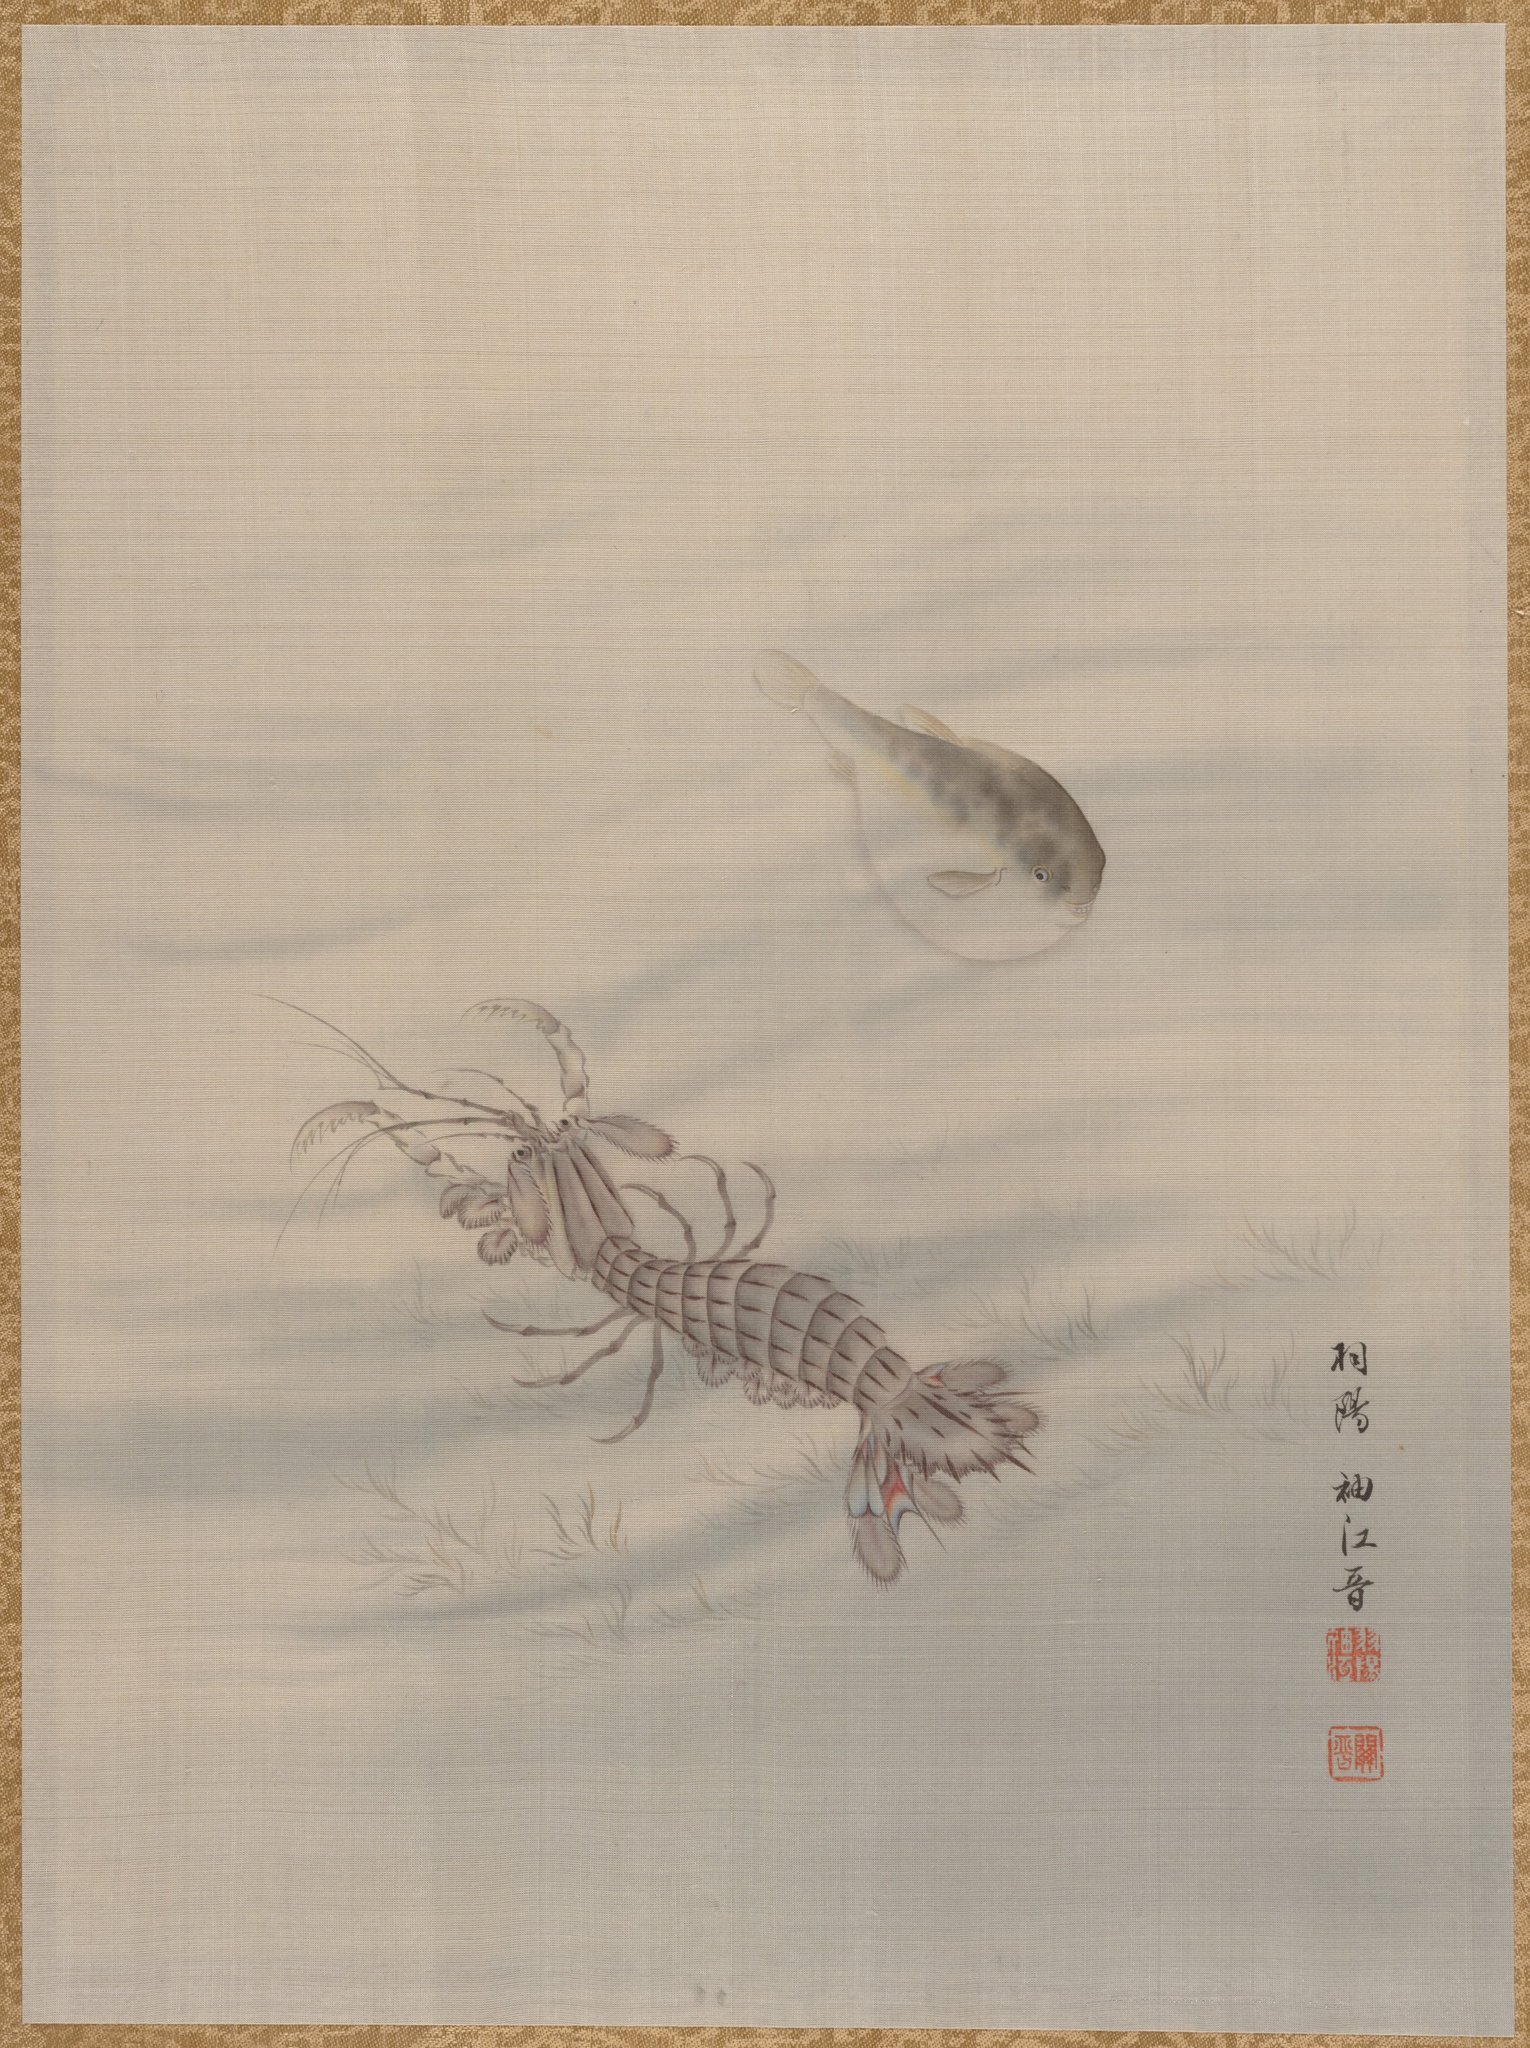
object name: album leaf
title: Bottom of the Sea Showing Cray Fish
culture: japanese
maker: seki shūkō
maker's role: artist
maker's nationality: japanese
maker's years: 1858-1915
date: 1890-1892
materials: silk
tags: crayfish